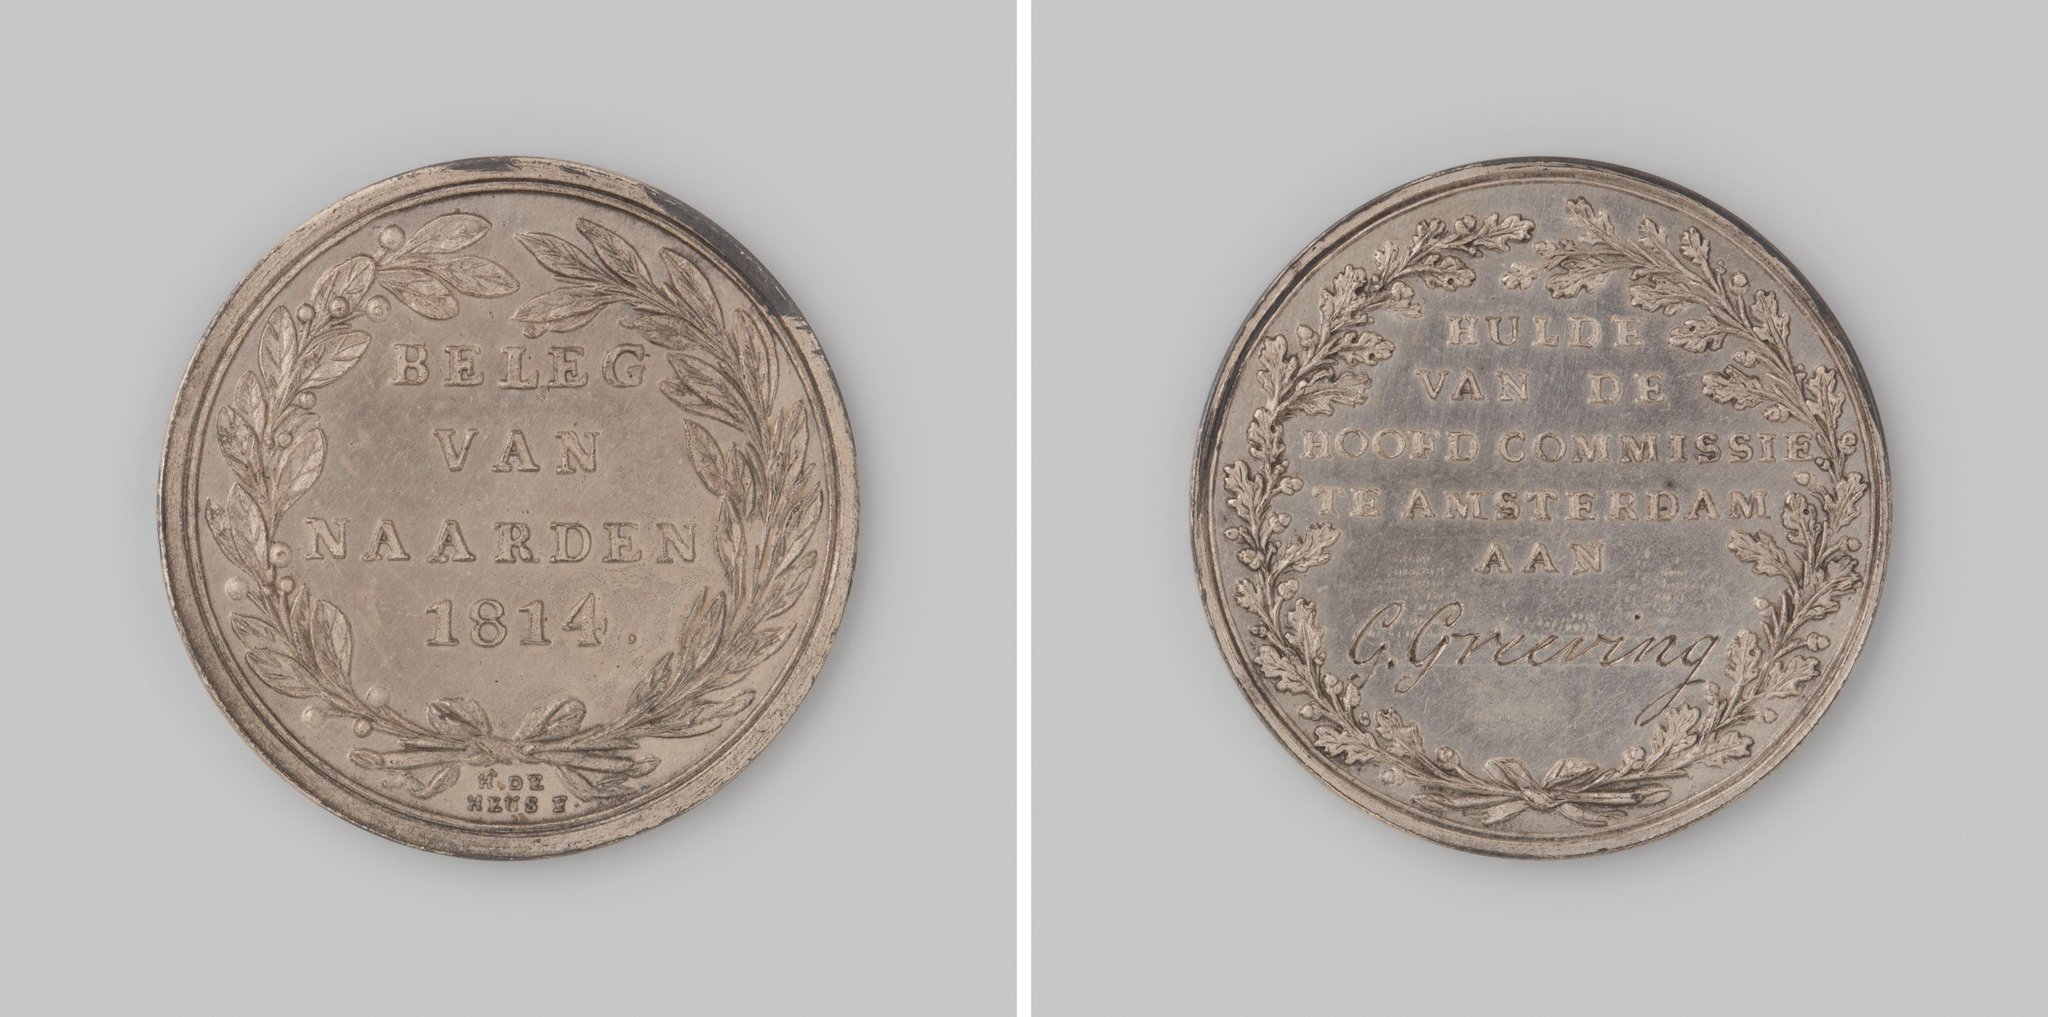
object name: honorary medal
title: Erepenning voor de schutters bij het beleg van Naarden, op naam van G. Greeving, lid van de schutterij te Amsterdam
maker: hendrik de heus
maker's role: medailleur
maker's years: -1838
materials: silver